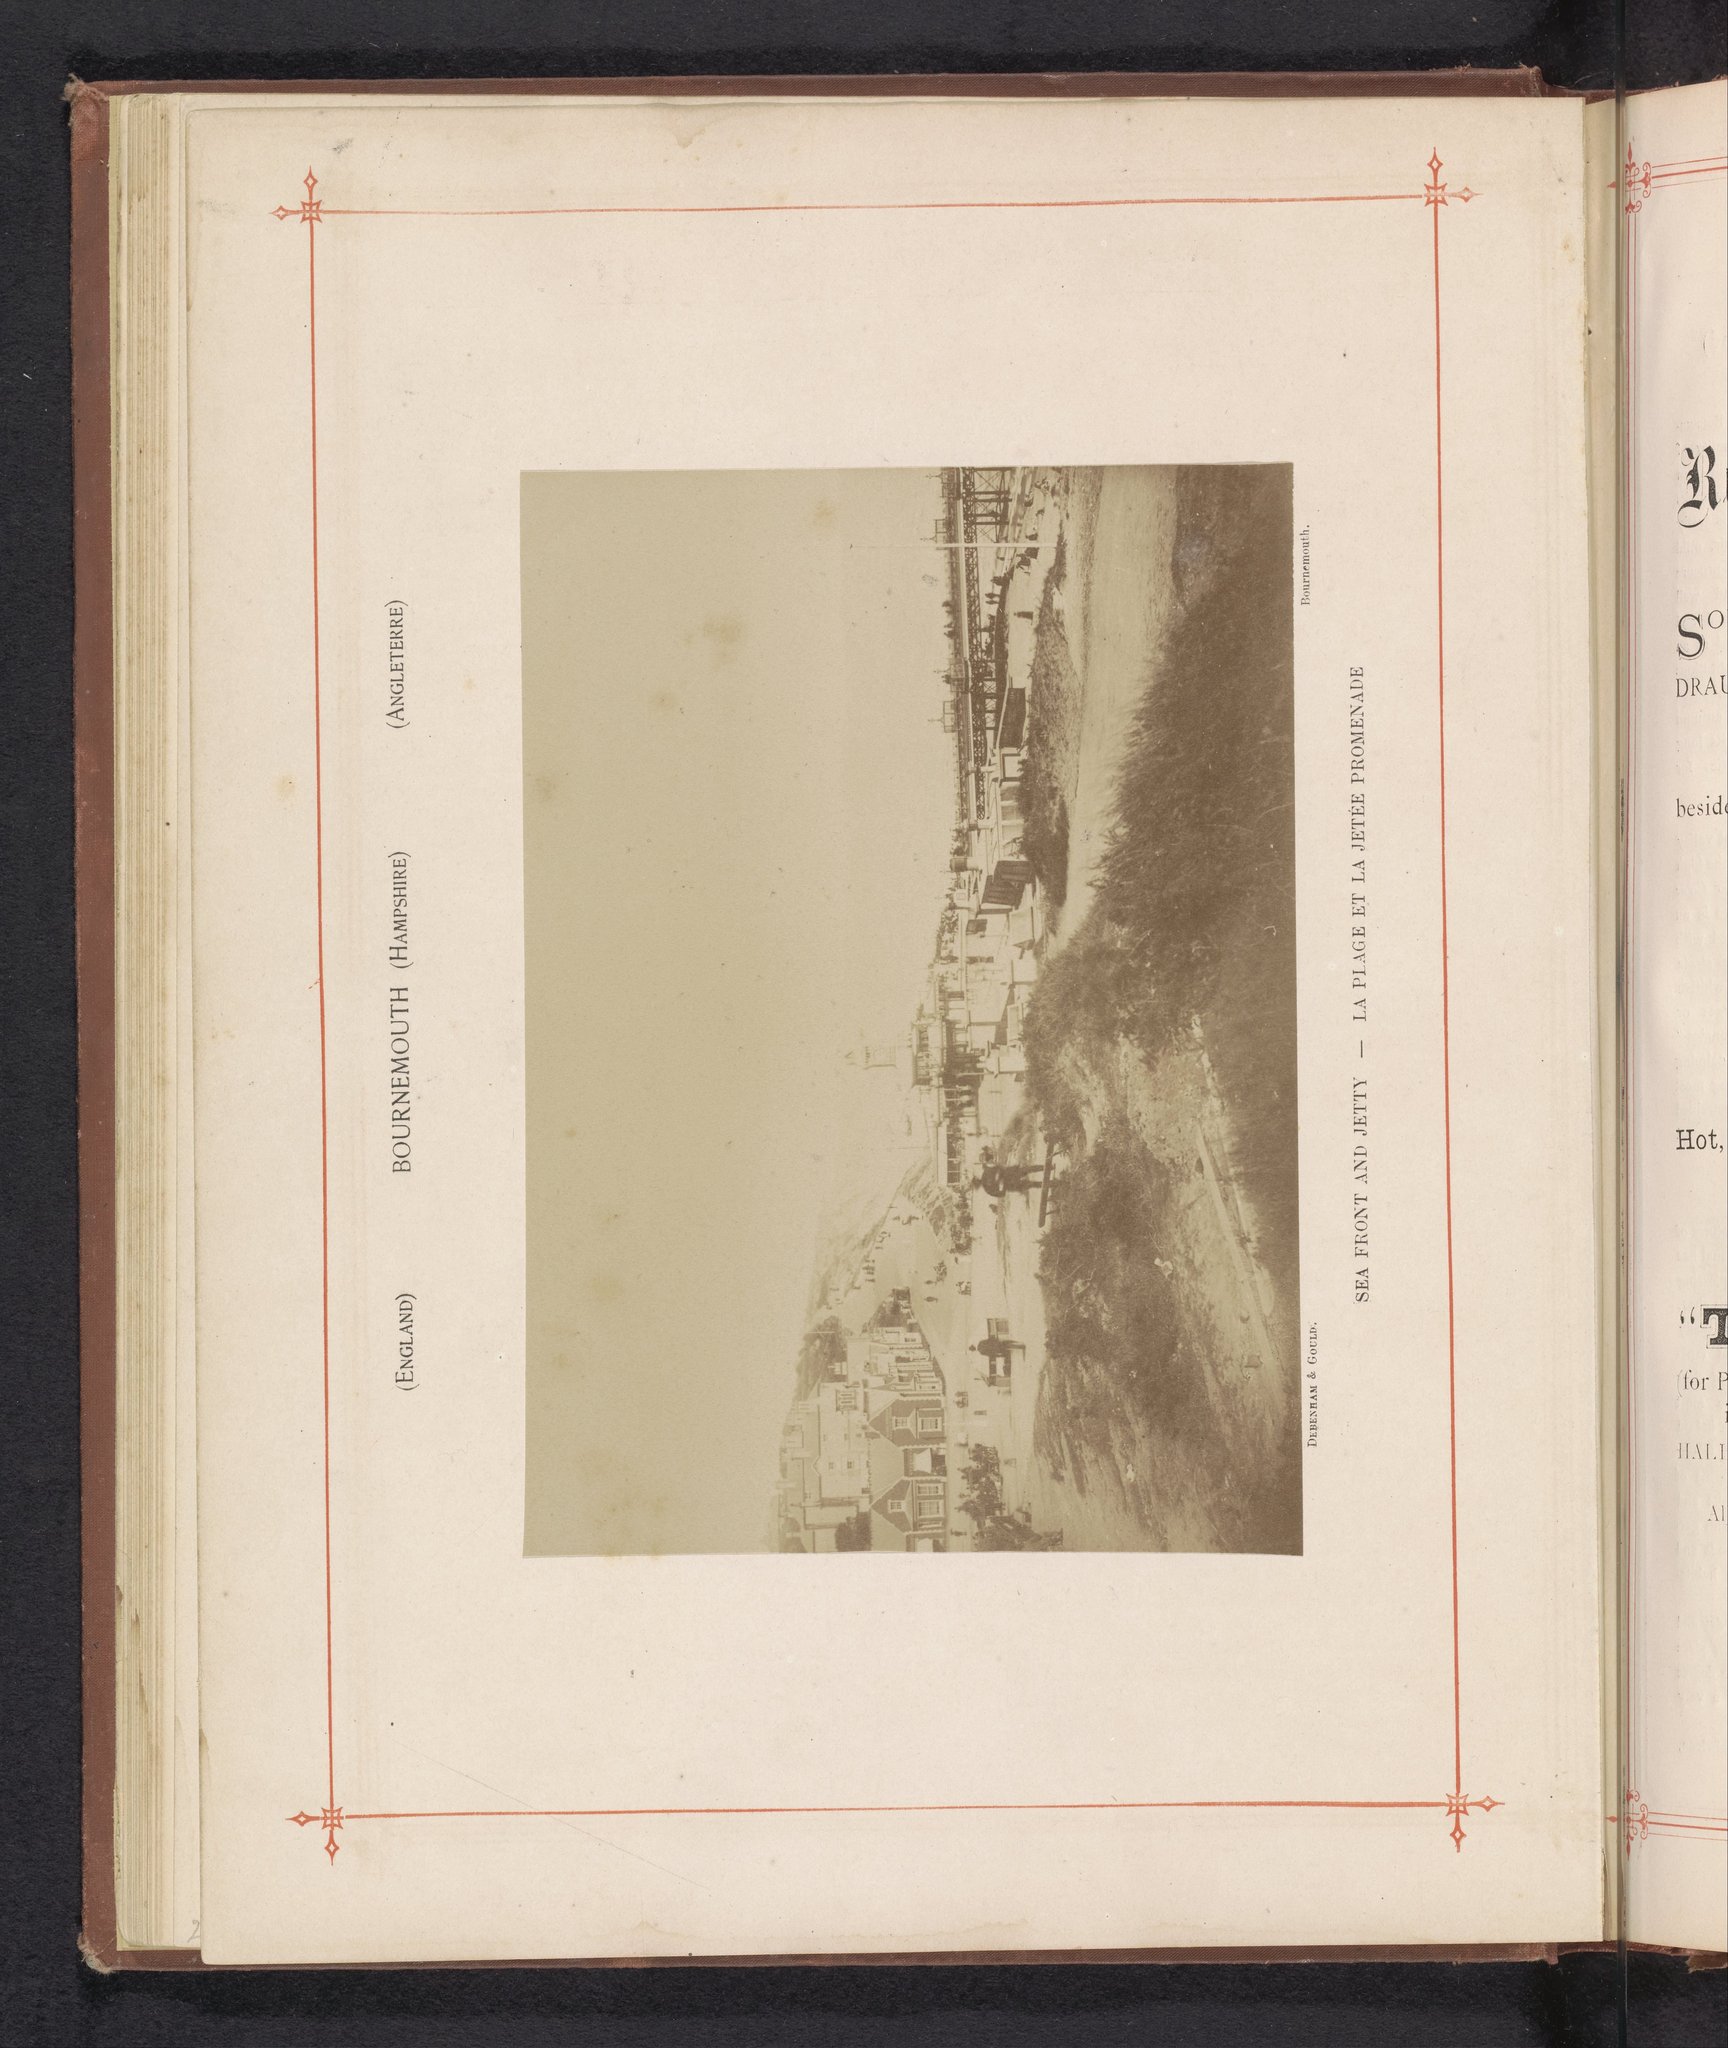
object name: photograph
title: Sea front and jetty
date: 1876-1886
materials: photographic support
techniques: albumen print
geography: bournemouth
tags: coast, quay